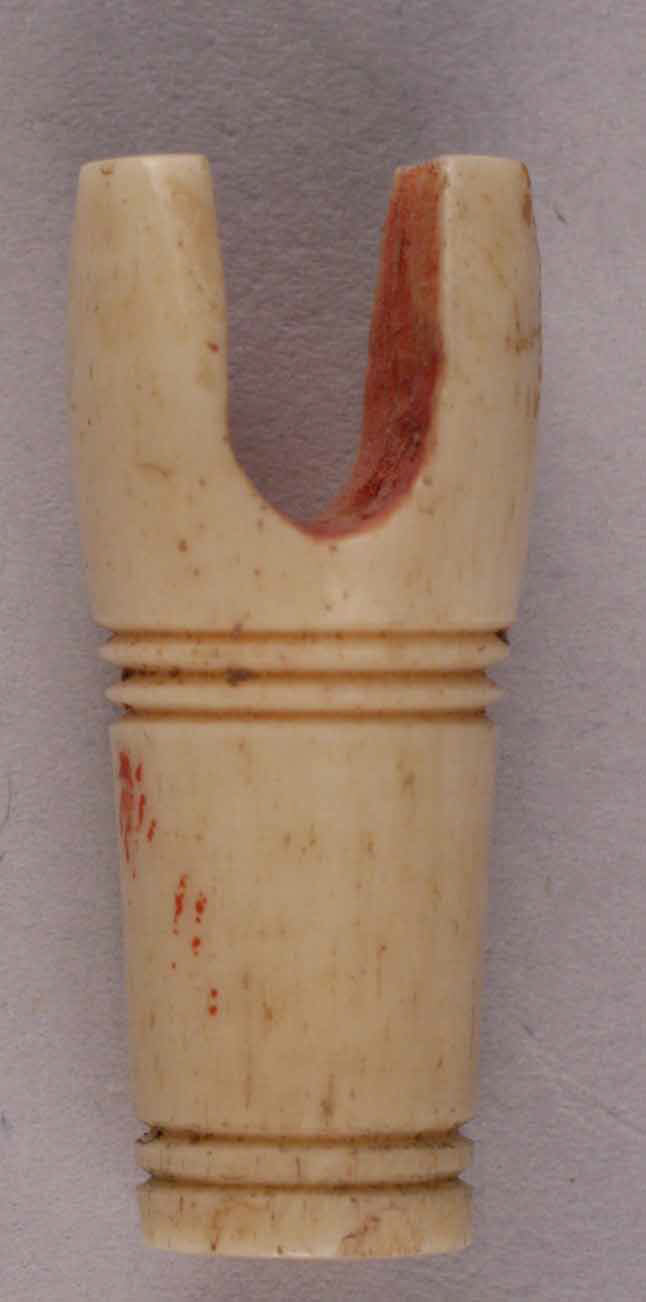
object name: nock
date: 801-1000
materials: bone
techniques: carving, incising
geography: iran